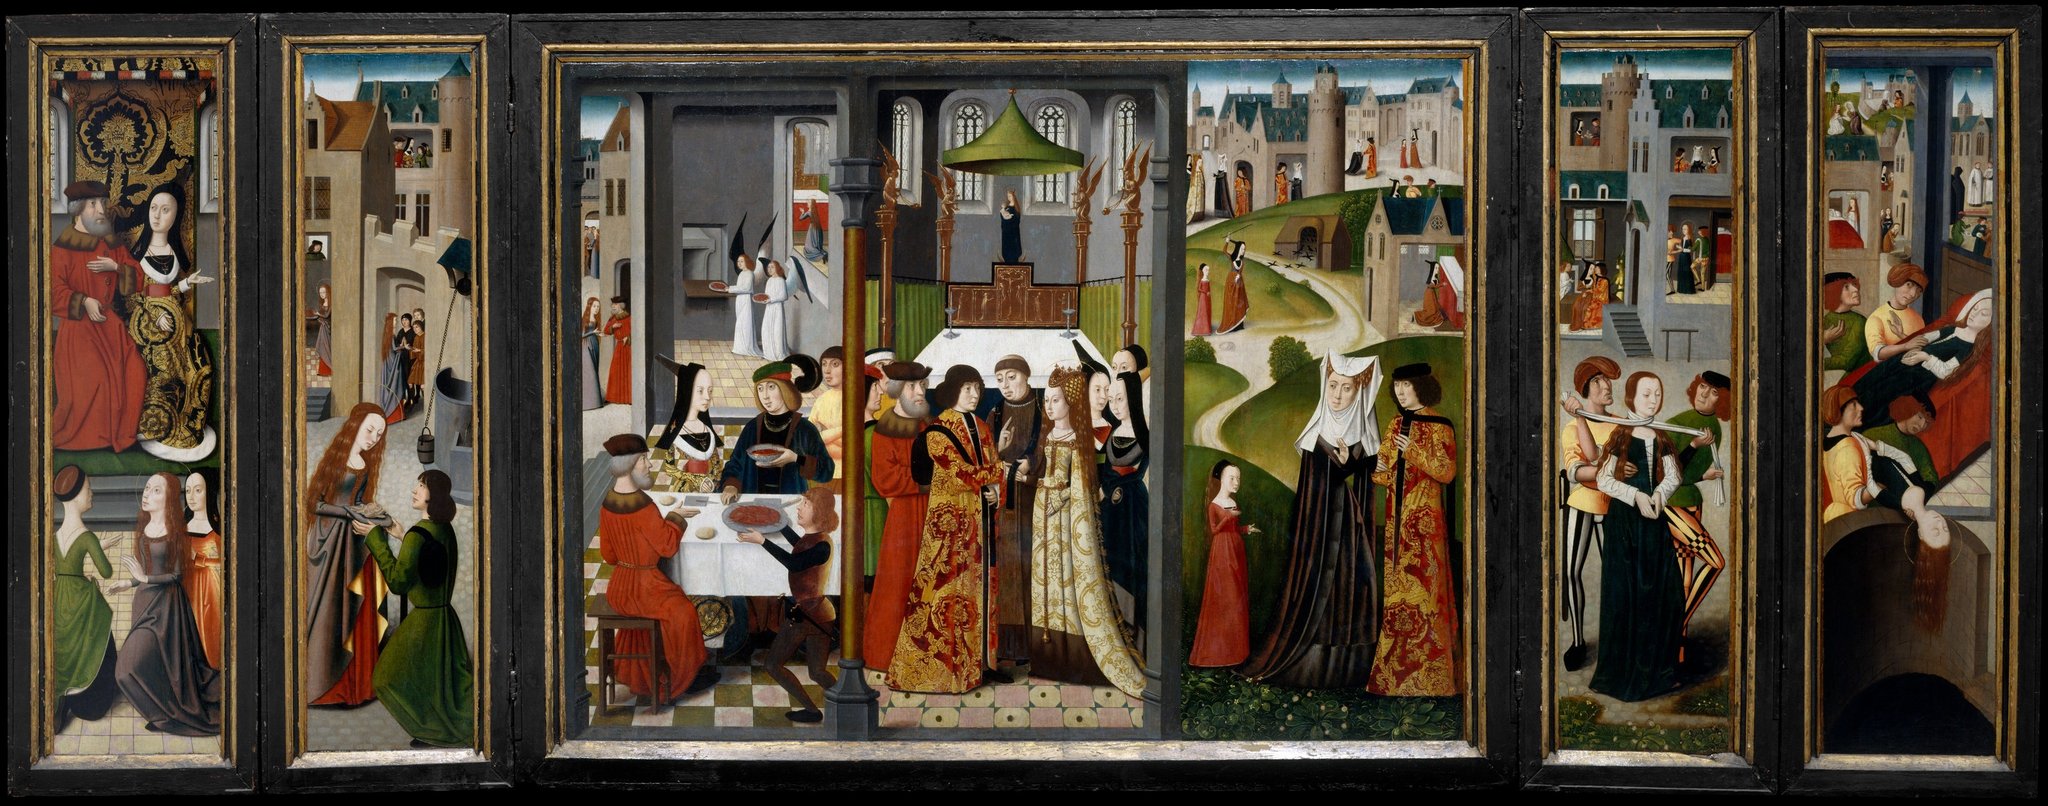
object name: painting, polyptych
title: The Life and Miracles of Saint Godelieve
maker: master of the saint godelieve legend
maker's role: artist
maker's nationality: netherlandish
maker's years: 1475-1499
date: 1475-1499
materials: oil, wood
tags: interiors,women,saints,dining,weddings